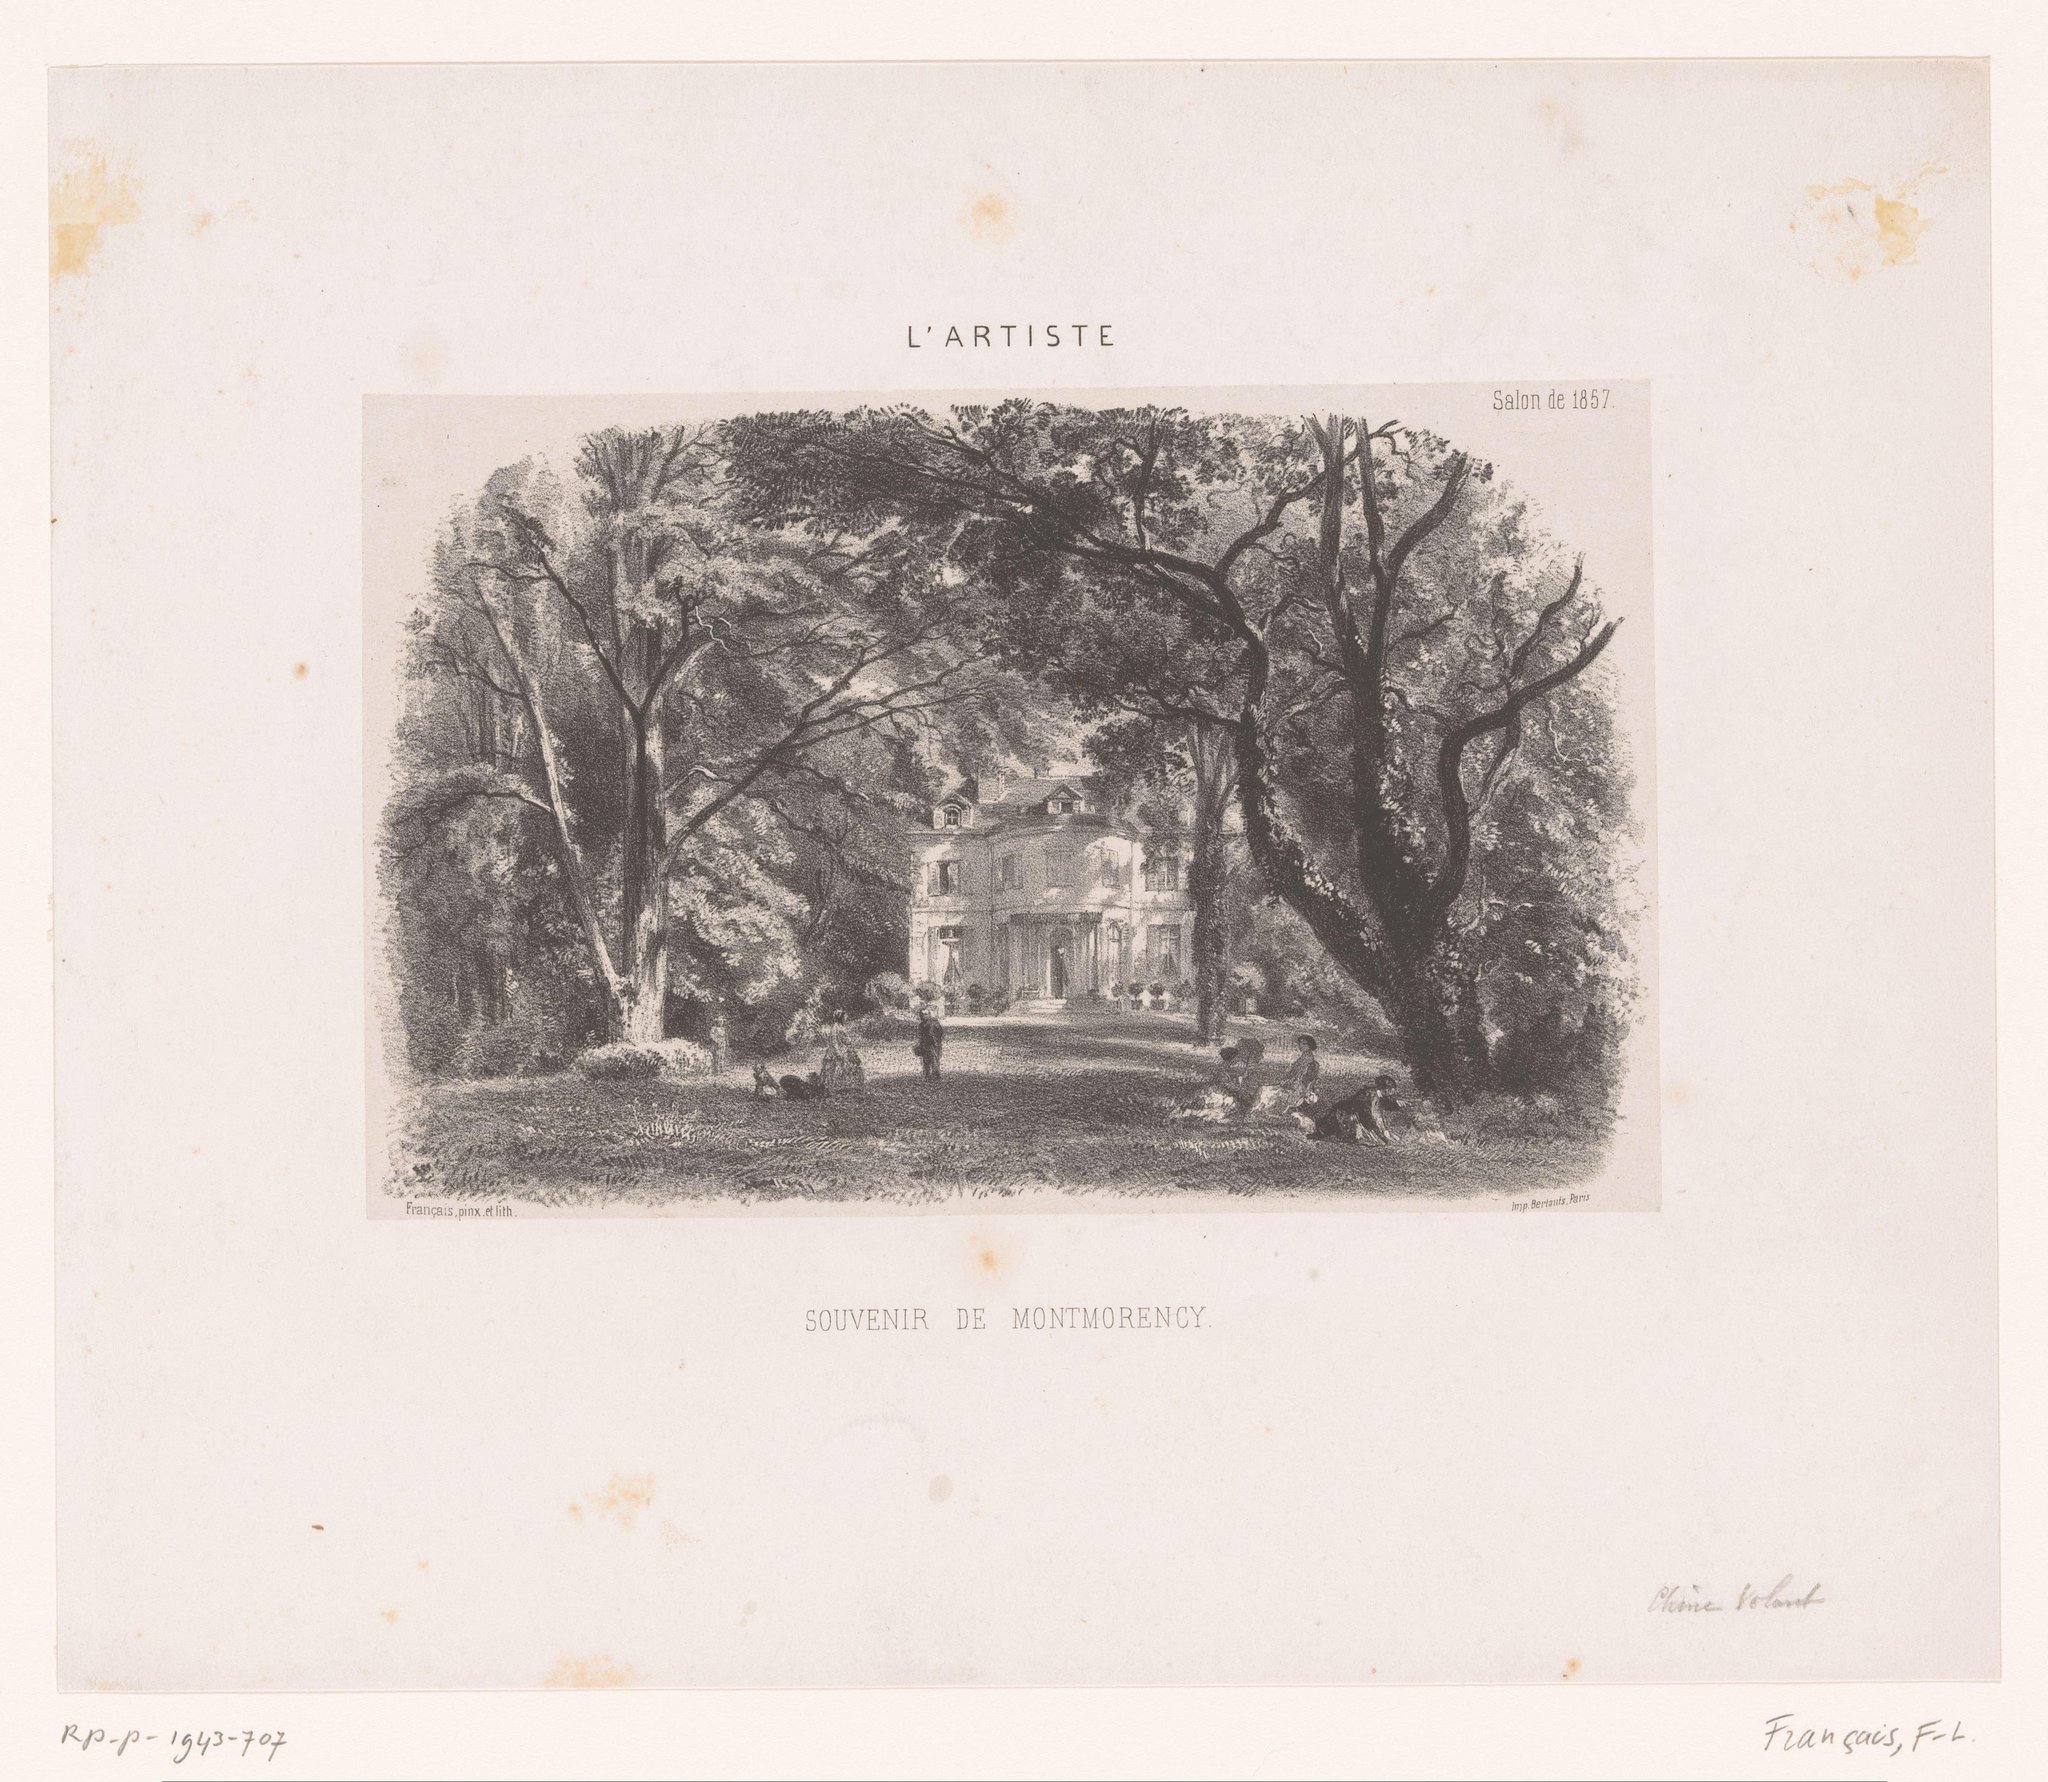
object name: print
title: Zicht op het kasteel van Montmorency tussen de bomen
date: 1857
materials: paper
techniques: lithograph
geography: paris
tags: public gardens, park (+ city(-scape) with figures, staffage), castle, landscape with tower or castle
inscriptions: collector's mark: Lugt 2228a